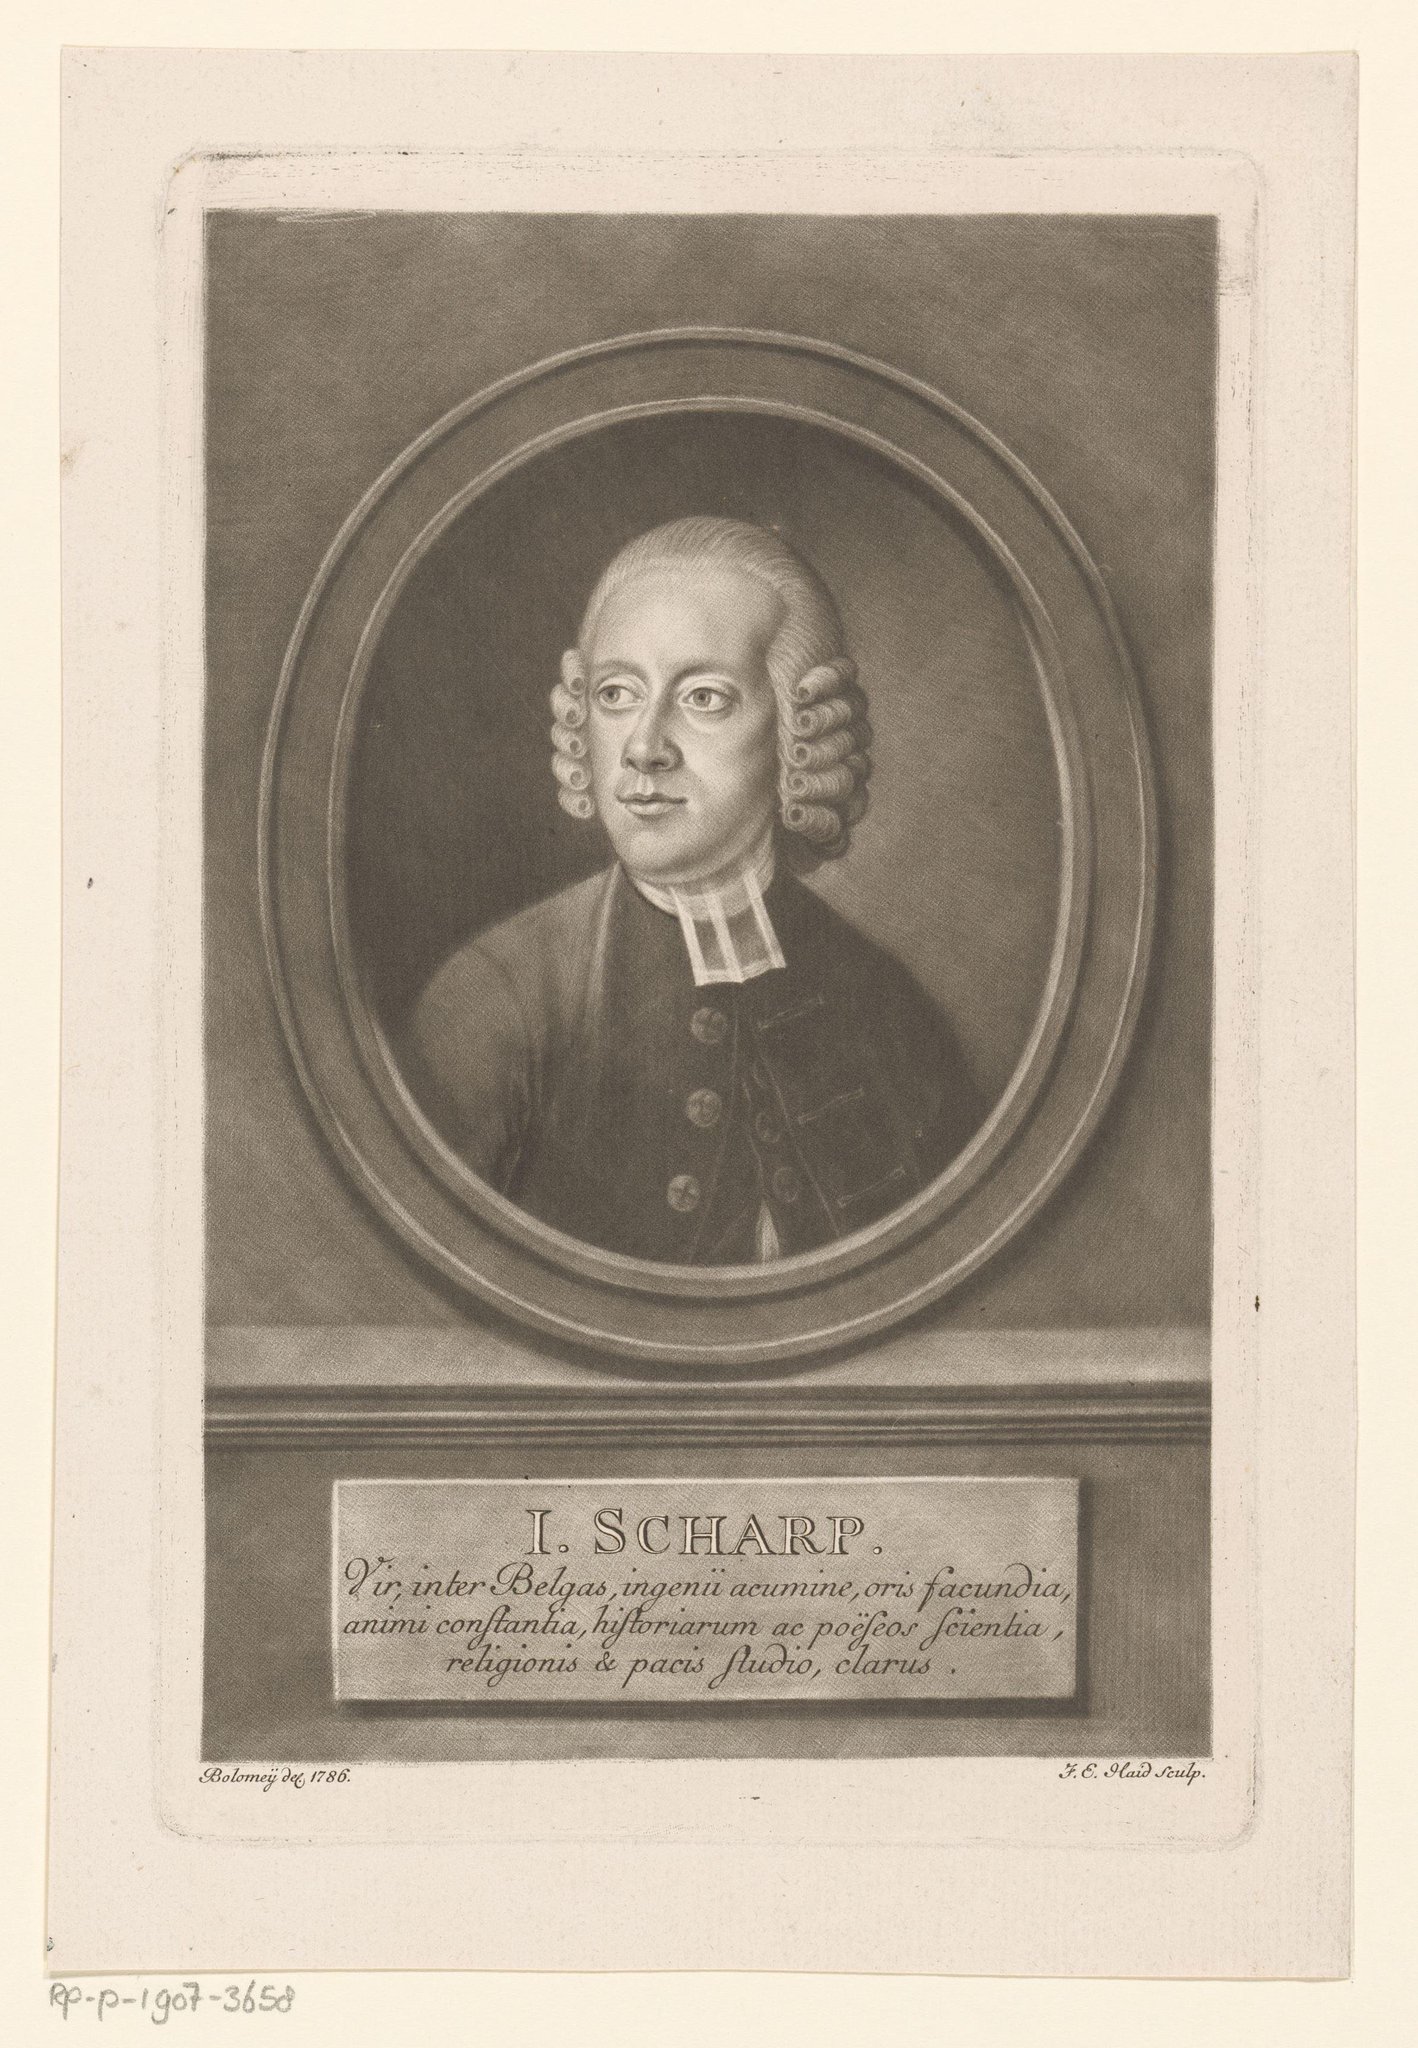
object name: print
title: Portret van Jan Scharp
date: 1786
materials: paper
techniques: mezzotint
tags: the hague, rotterdam, jan scharp, historical persons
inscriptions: collector's mark: Lugt 2228